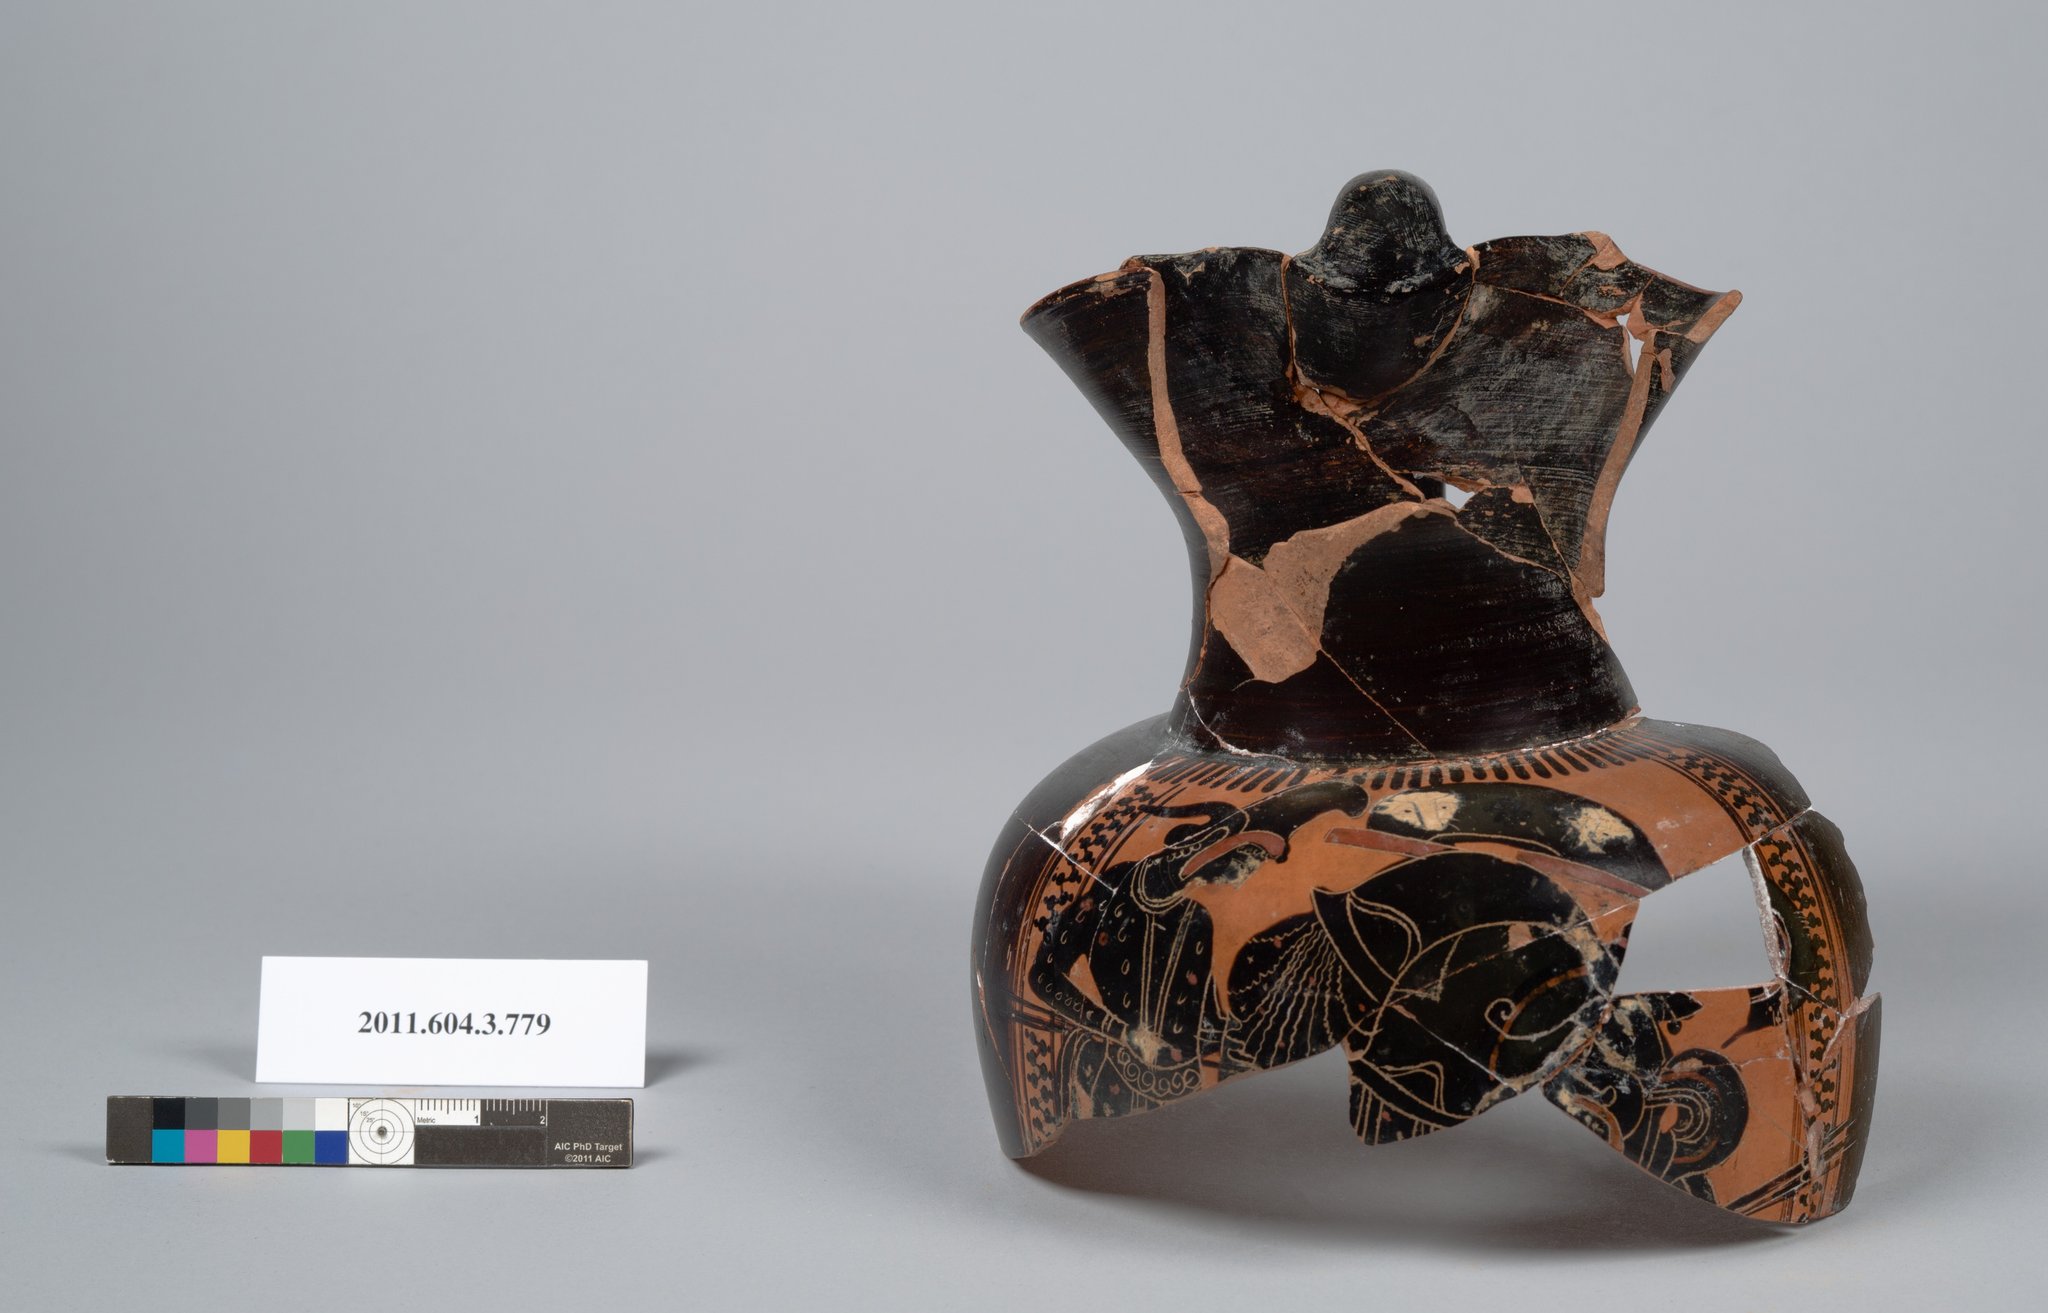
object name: oinochoe fragment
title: Terracotta fragments of an oinochoe (jug)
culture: greek, attic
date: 510 BCE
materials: terracotta